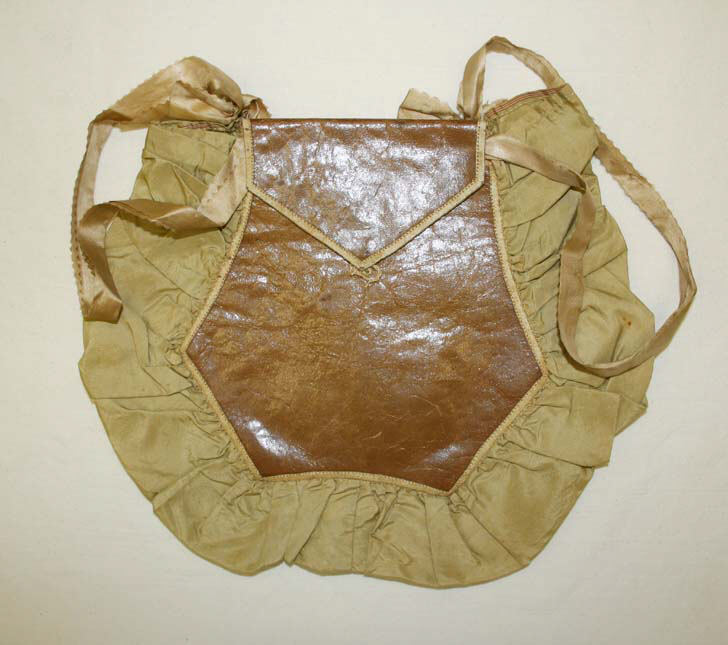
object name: bag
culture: american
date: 1825-1830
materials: cotton, leather, silk